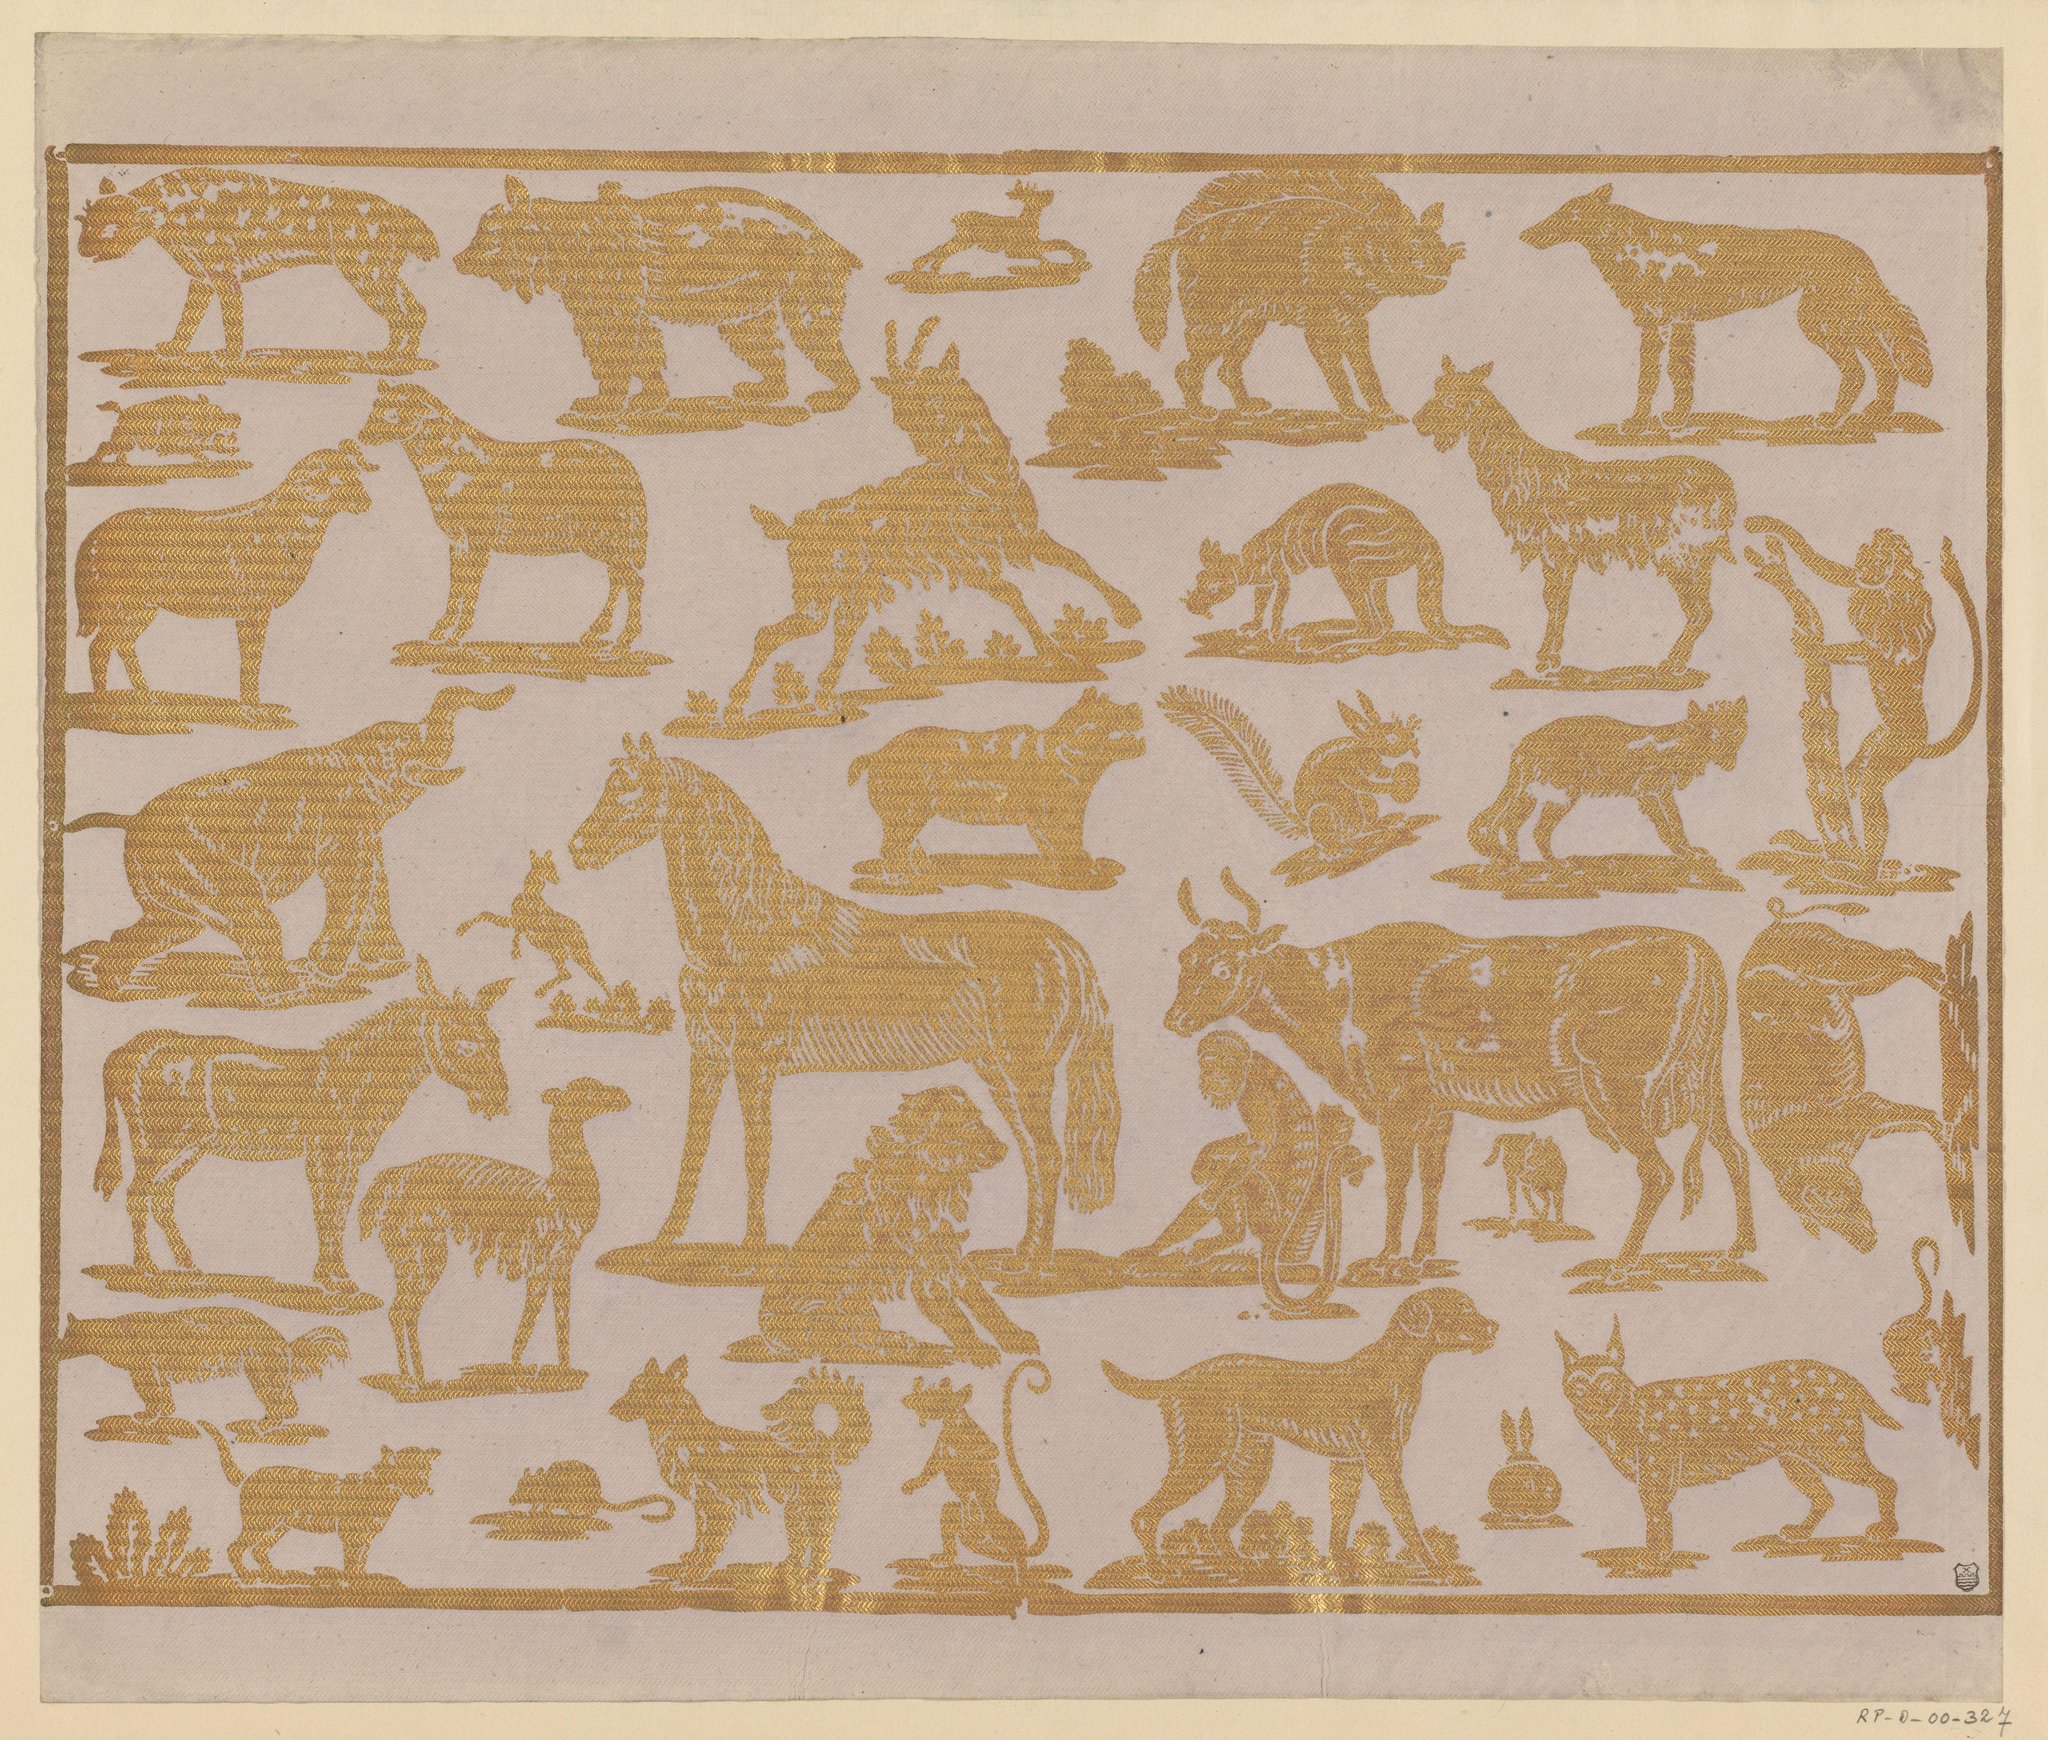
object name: brocade paper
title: Blad met verschillende dieren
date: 1850-1920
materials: gold leaf, paint, paper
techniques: machining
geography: aschaffenburg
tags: mammals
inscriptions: collector's mark: Lugt 2760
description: Blad met verschillende dieren, linksboven een hyena, rechtsboven een hond of wolf, linksonder een kat, rechtsonder een lynx.